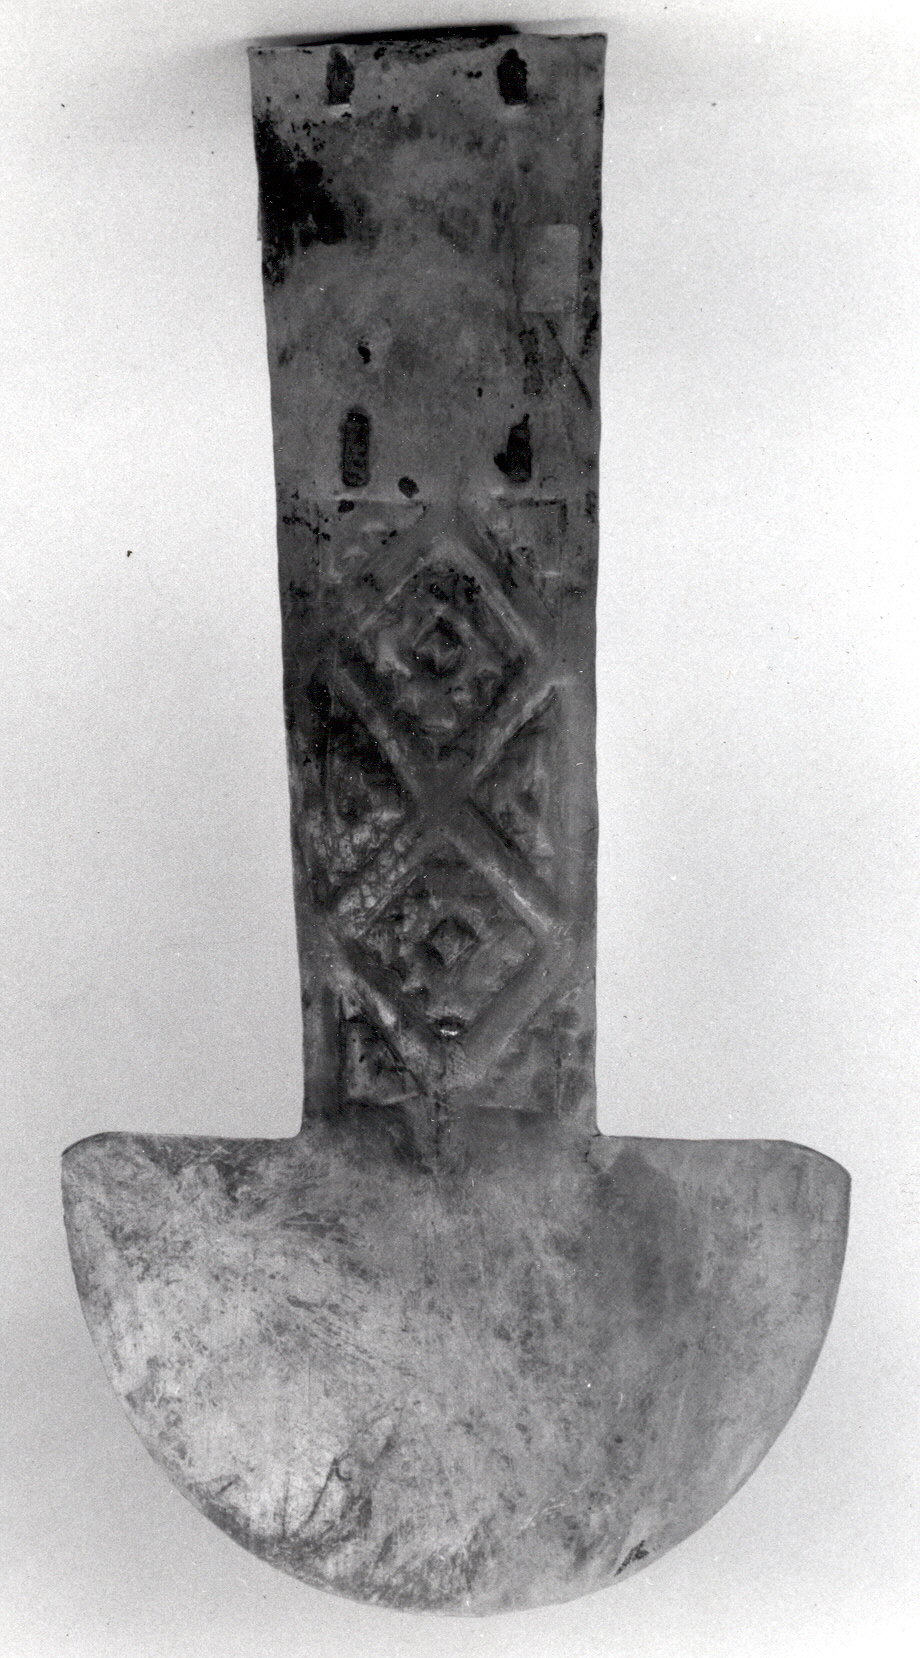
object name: knife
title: Gold Tumi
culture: chimú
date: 1101-1500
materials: gold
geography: peru